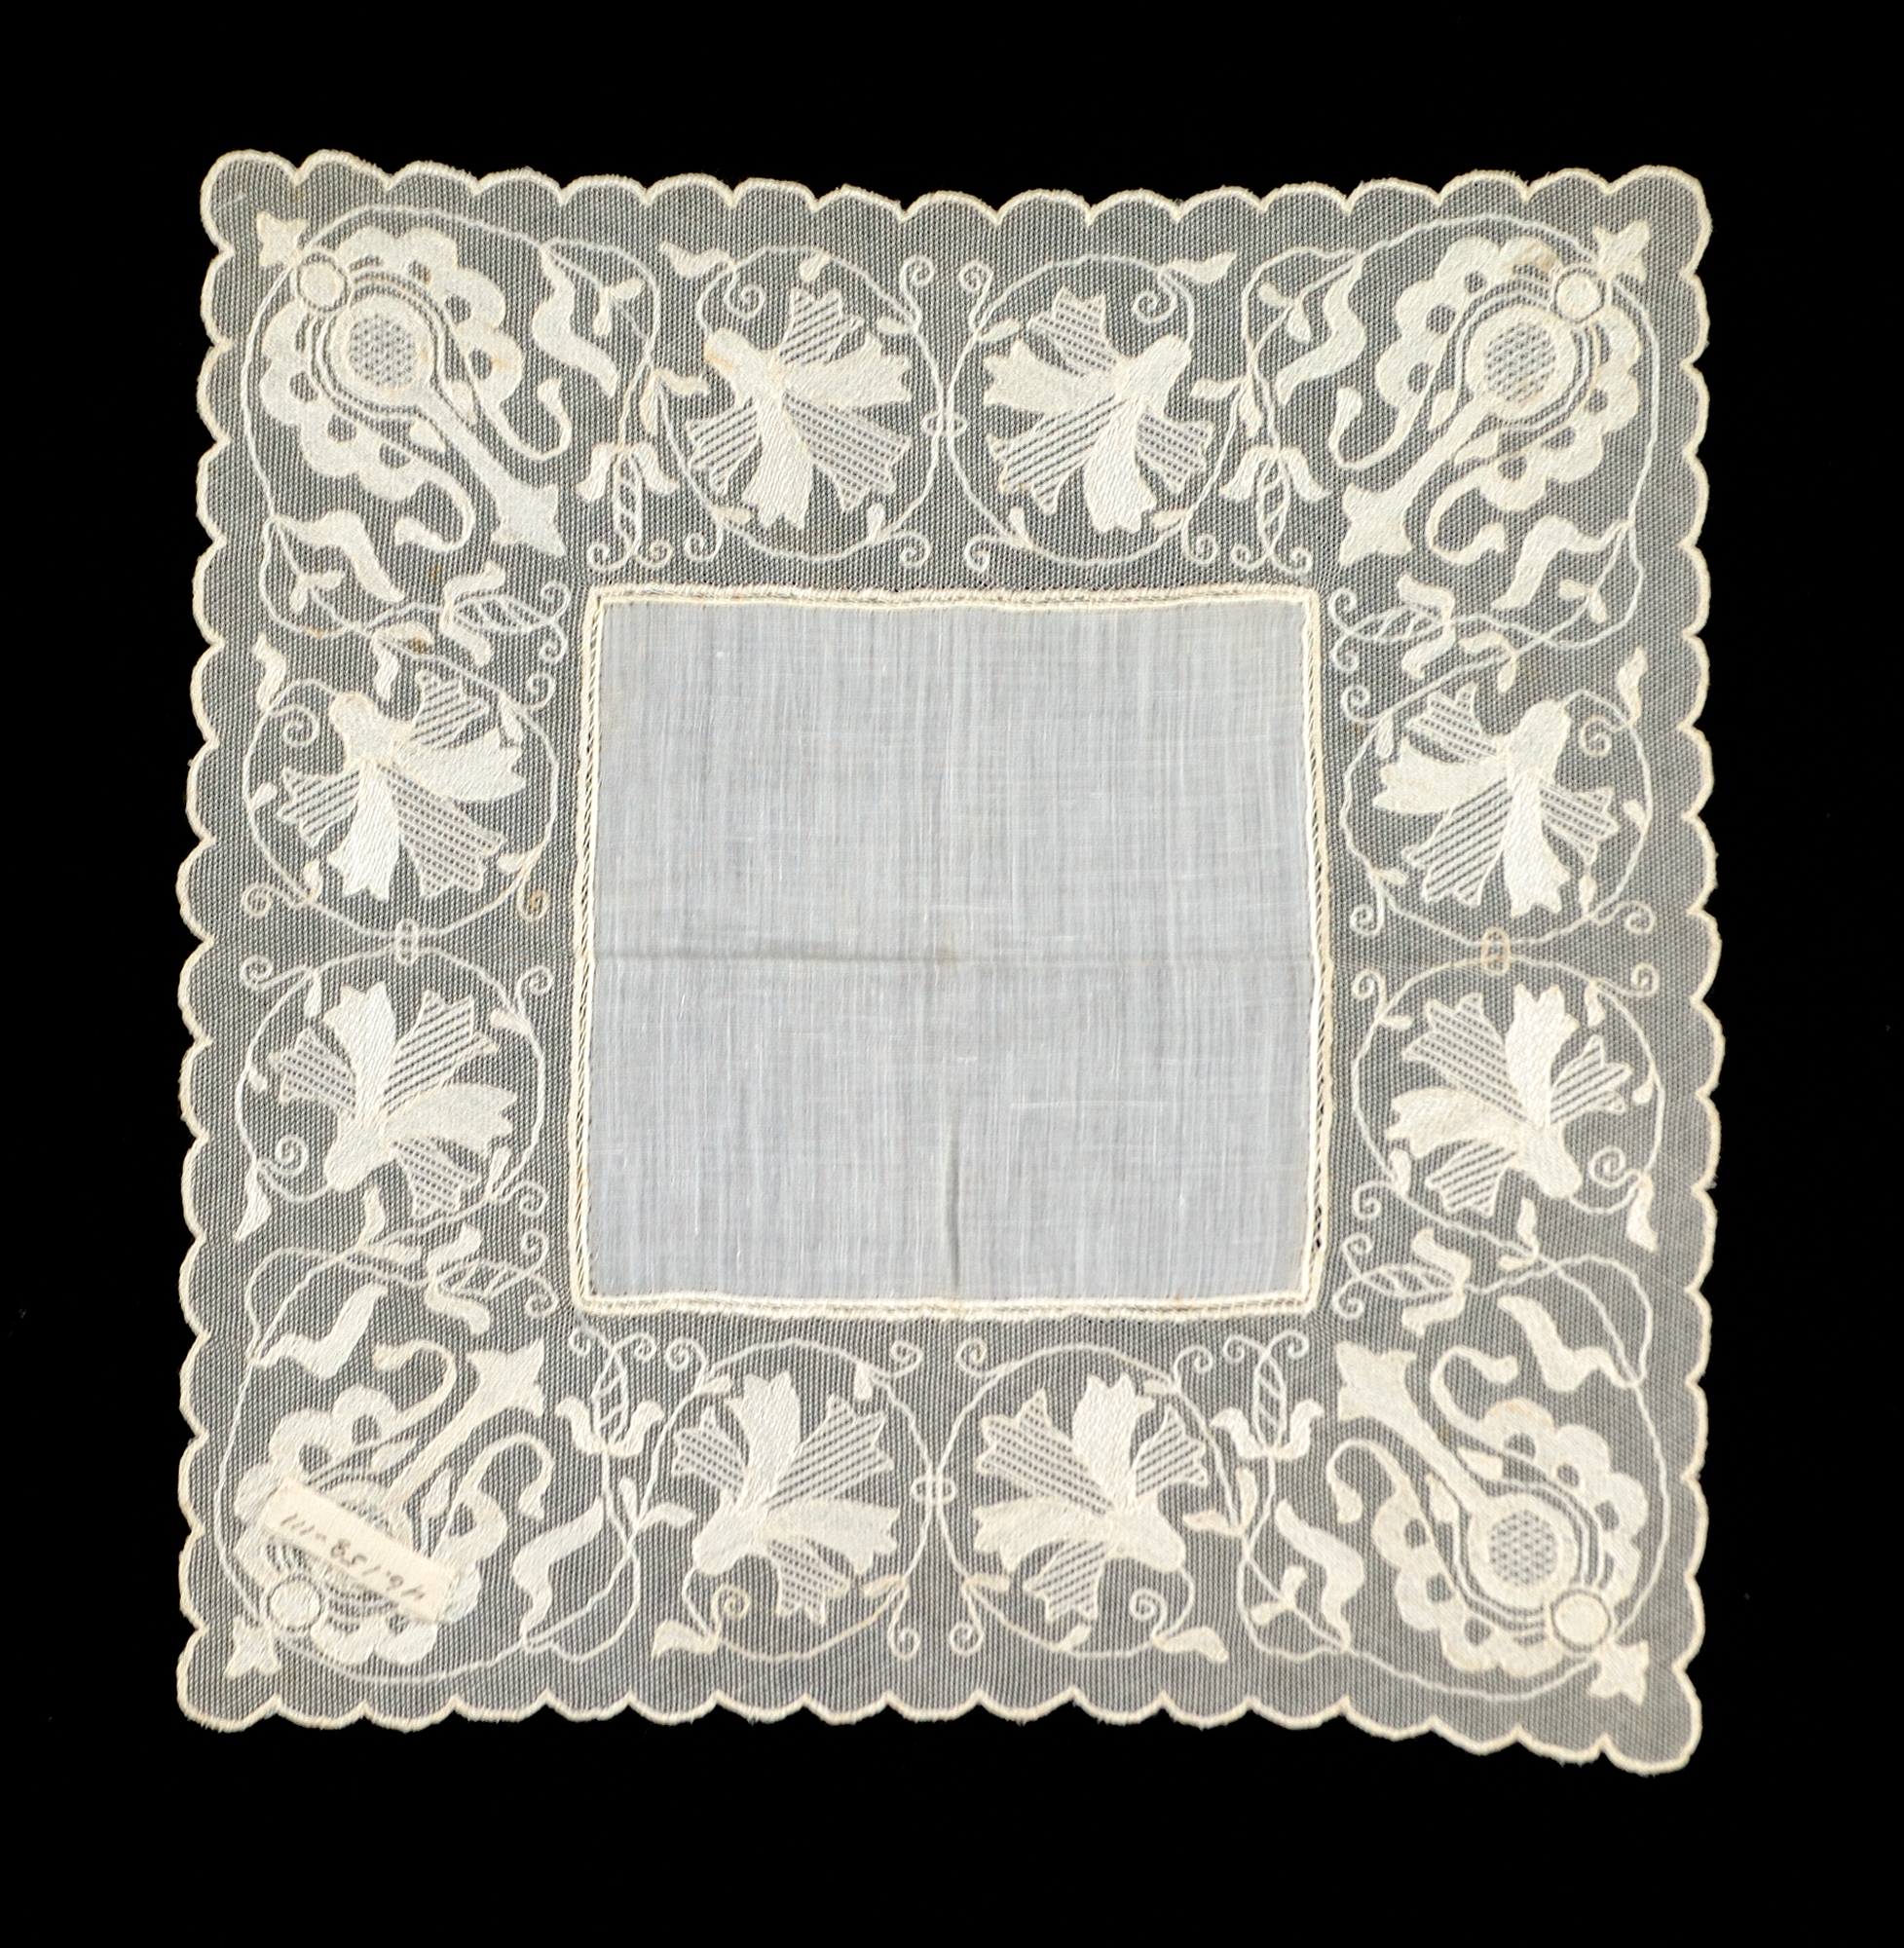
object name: handkerchief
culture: hungarian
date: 1886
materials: linen, silk